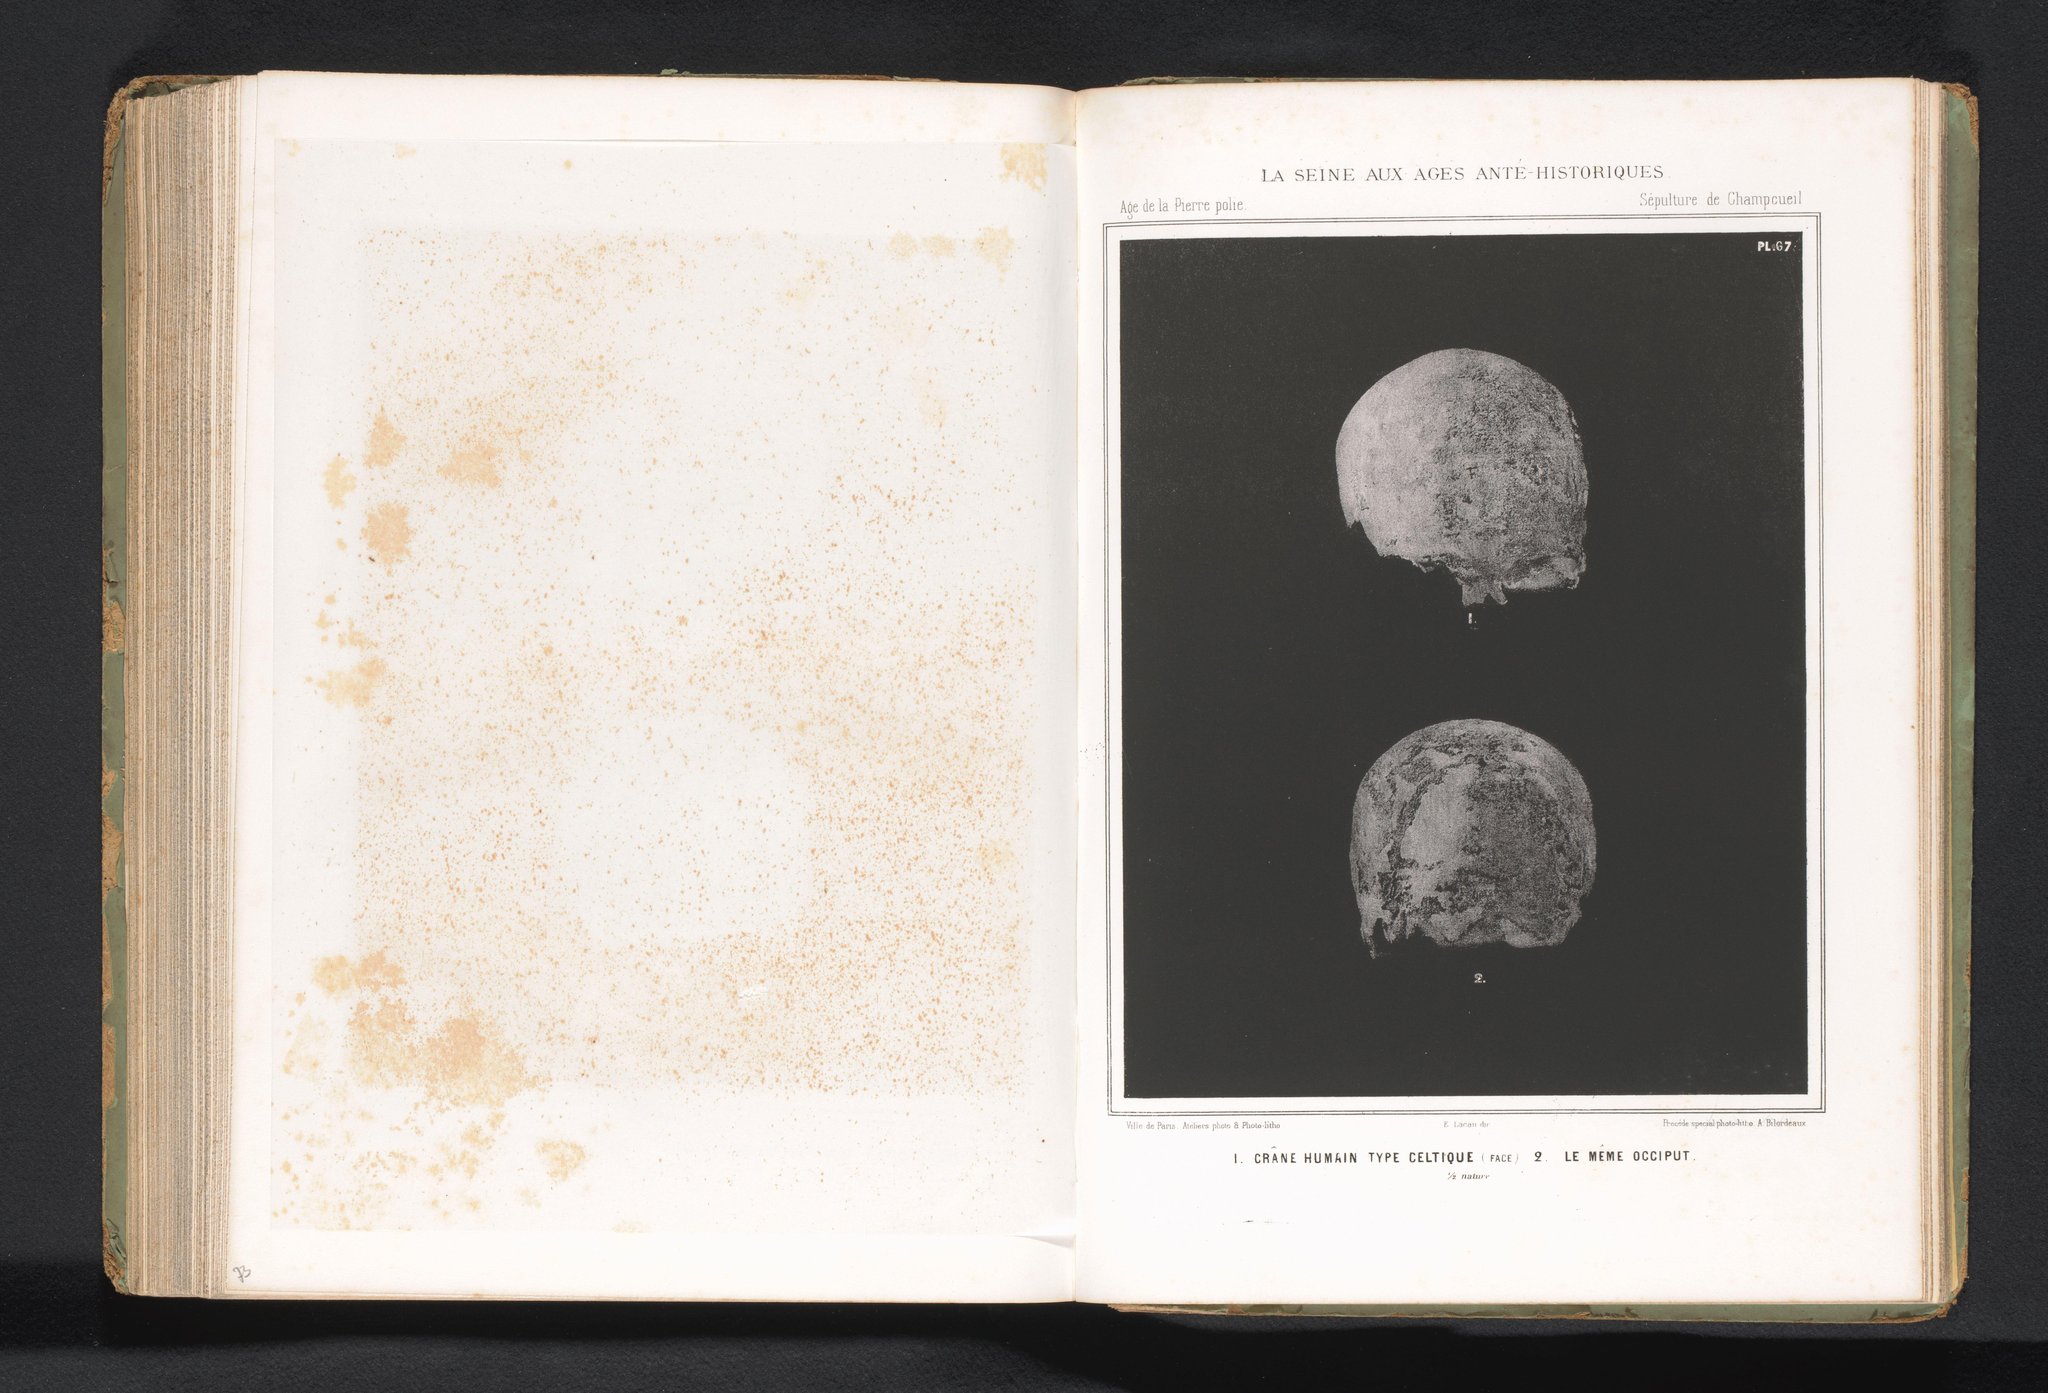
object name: photomechanical print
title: Twee aanzichten van een menselijke schedel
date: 1864-1869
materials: paper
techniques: photolithography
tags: (human) skull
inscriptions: inscription: ‘1/2 nature’, inscription: ‘PL.67’, inscription: ‘1. CRÂNE HUMAIN TYPE CELTIQUE (FACE) 2. LA MÊME OCCIPUT.’, inscription: ‘Procédé spécial photo-litho. A. Bilordeaux’